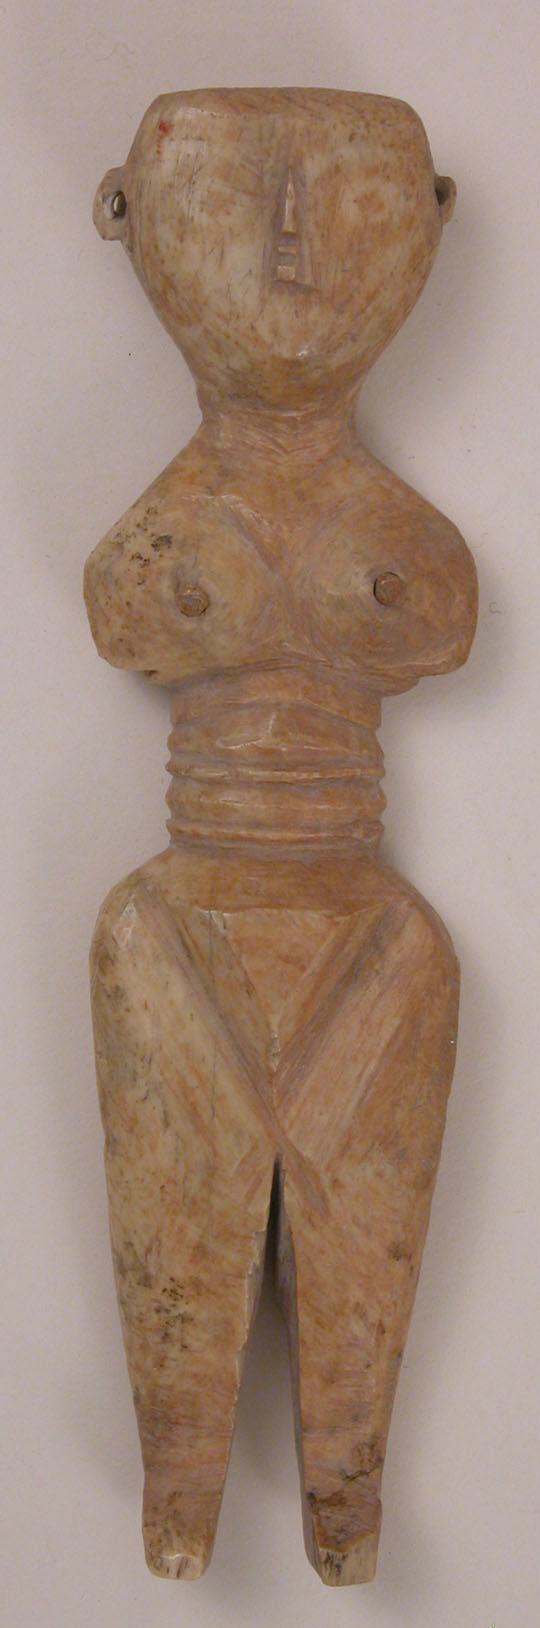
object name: figure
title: Figurine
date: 1001-1200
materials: bone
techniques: carving, incising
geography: egypt